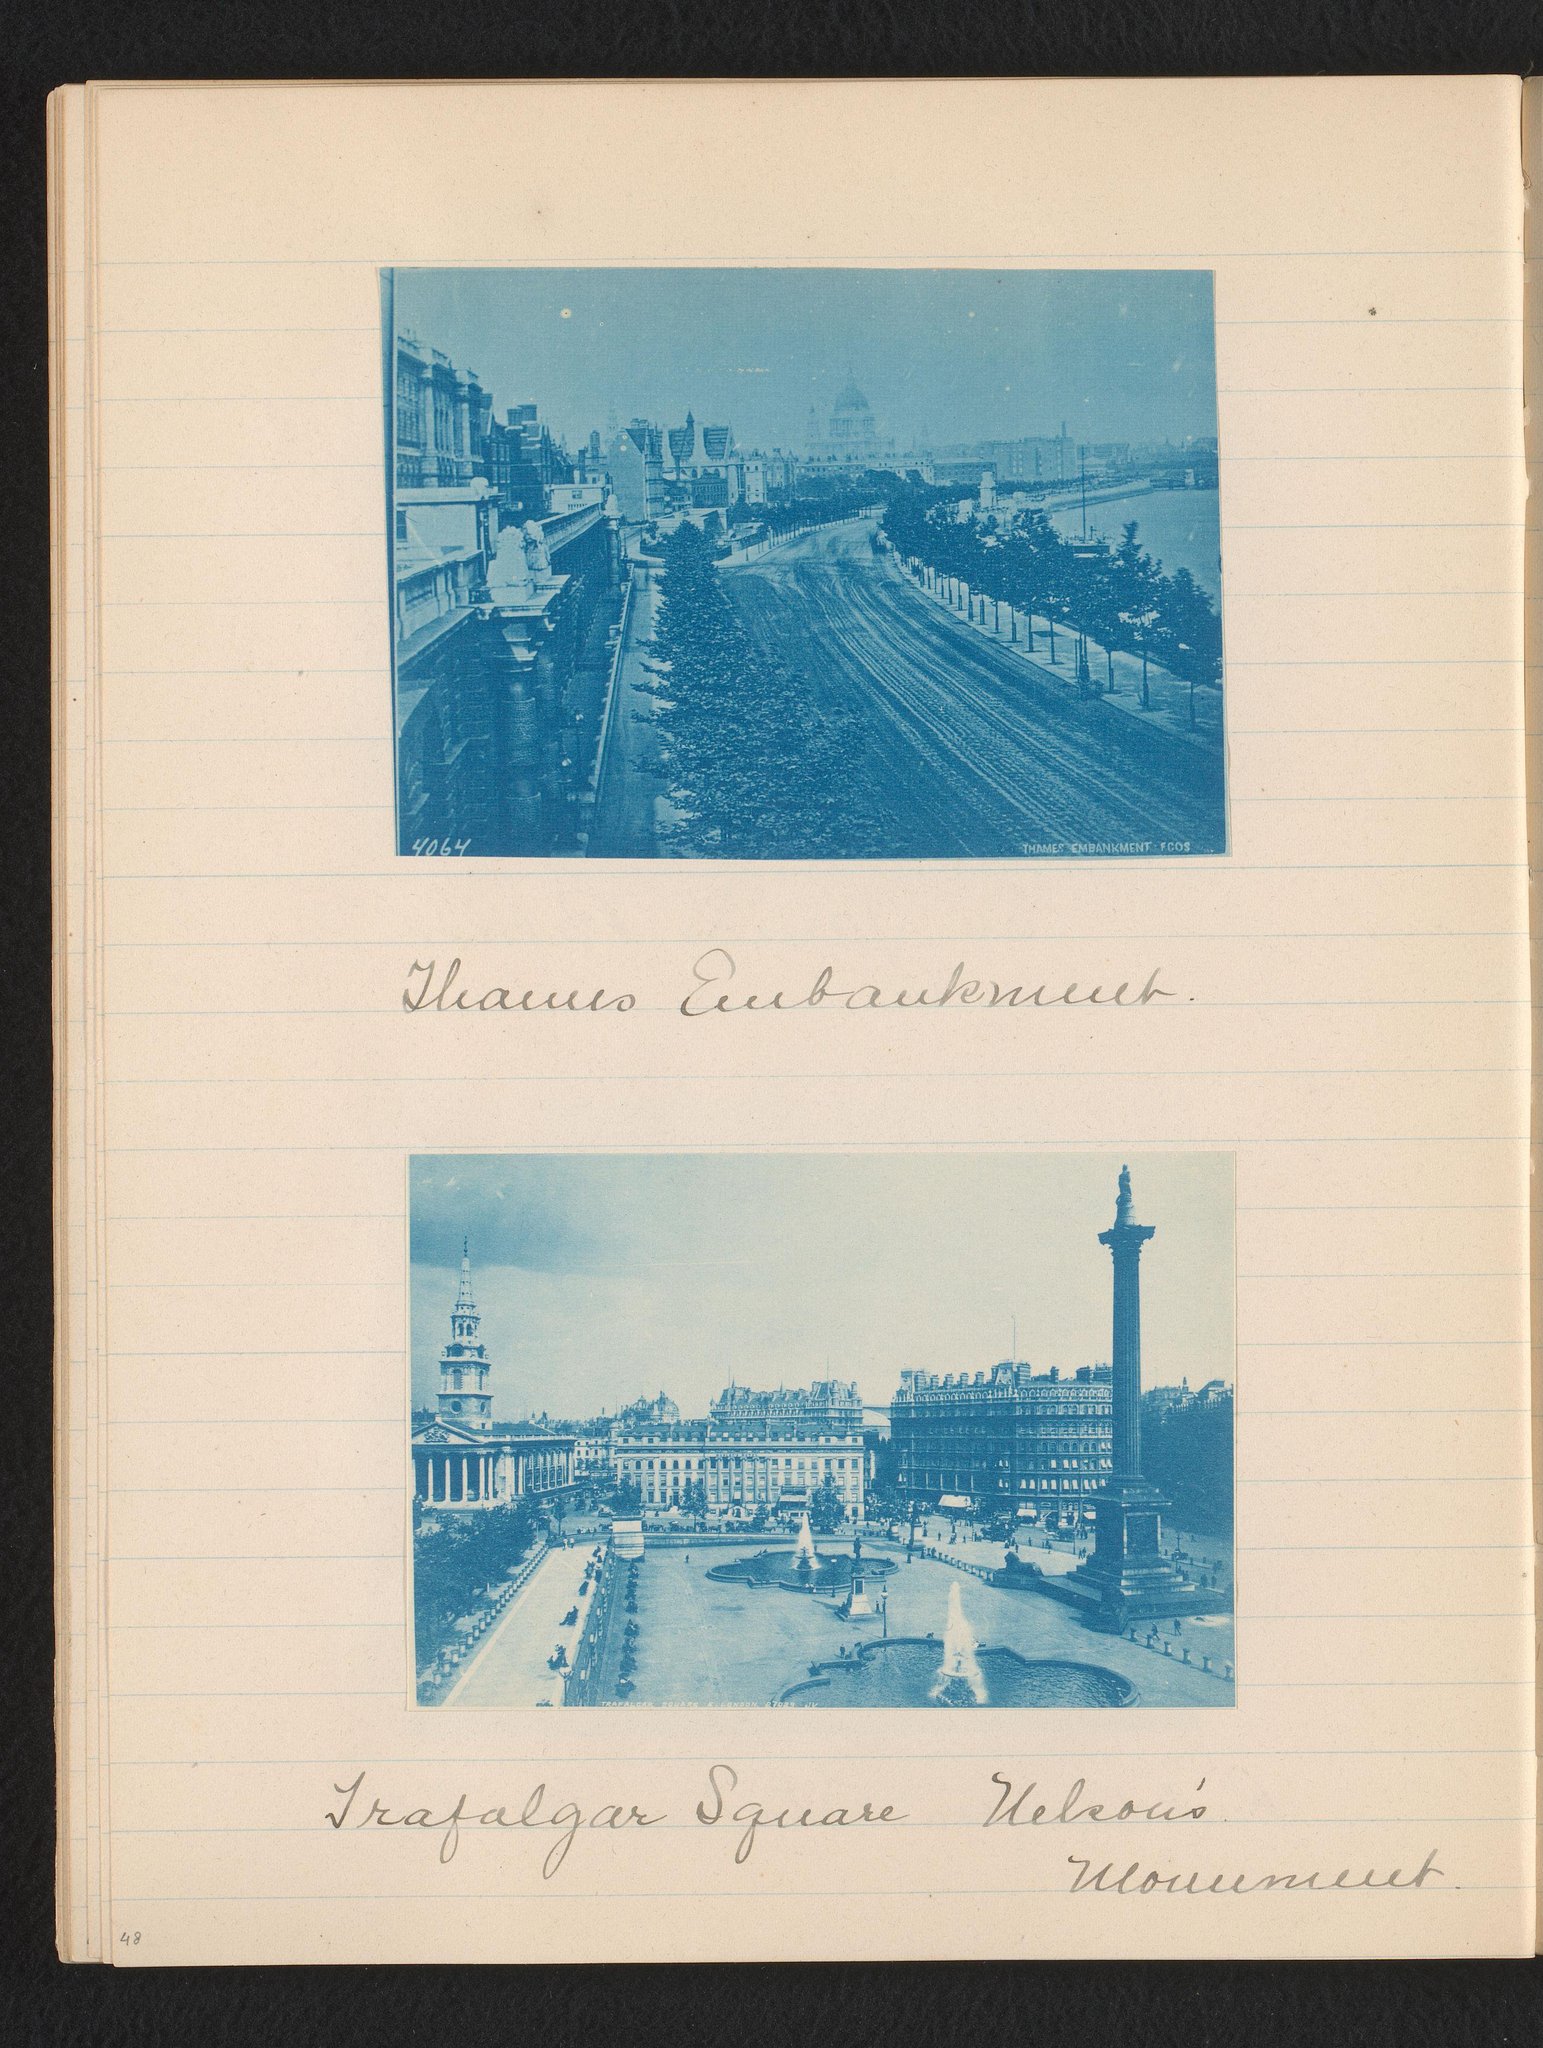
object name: album leaf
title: Twee foto's van de Thames Embankment en Trafalgar Square, Londen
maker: Anonymous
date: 1901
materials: paper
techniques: cyanotype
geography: london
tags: square, place, circus, etc., river bank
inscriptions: inscription: ‘Thames Embankment/ Trafalgar Square Nelson's/ Monument.’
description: Deze foto's maken deel uit van een album.